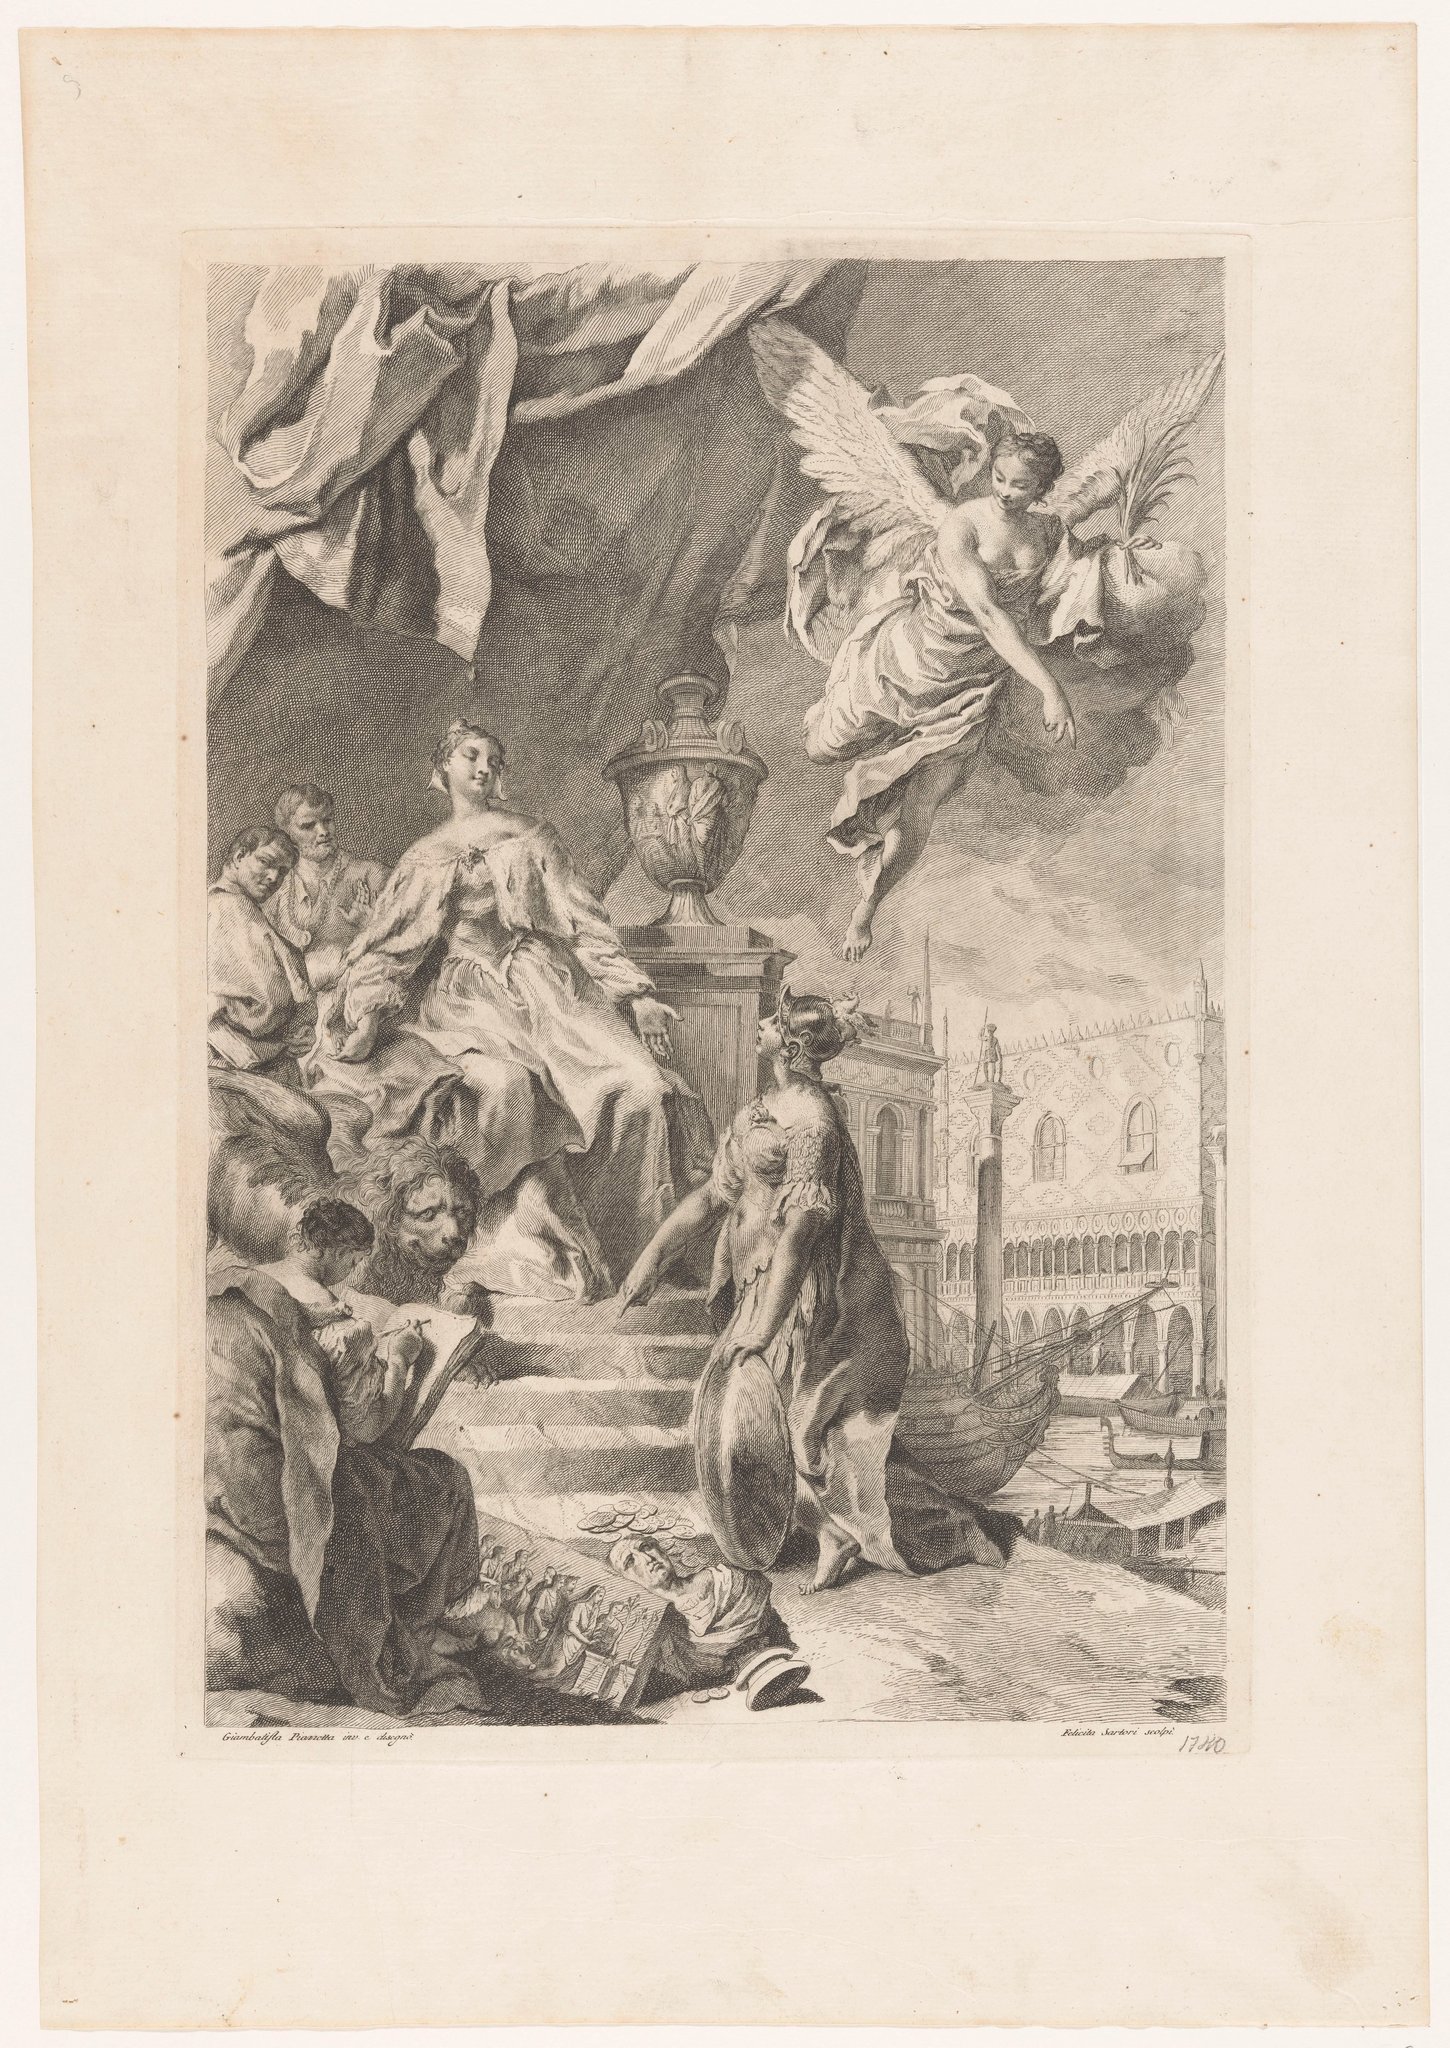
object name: print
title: Allegorie op Venetië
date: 1740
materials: paper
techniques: etching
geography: venice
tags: venice, painter, draughtsman, anton maria ii zanetti, anton maria i zanetti, fame; 'fama', 'fama buona', 'fama chiara' (ripa) (+ abstract concept represented by female figure), cities represented allegorically or symbolically, specific aspects, allegorical aspects of minerva; minerva as patroness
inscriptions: collector's mark: Lugt 2228, collector's mark: Lugt 2760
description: Allegorie op Venetië. Minerva brengt eerbetoon en geschenken staande voor de stedenmaagd gezeten op haar troon. Aan de zijde van Venetië een gevleugelde leeuw, achter haar de twee auteurs Zanetti. . Rechts op de achtergrond een deel van het Dogepaleis (Palazzo Ducale) en standbeeld van de heilige Theodorus, beschermheilige van Venetië, op een zuil aan het San Marcoplein. In de lucht de Faam.